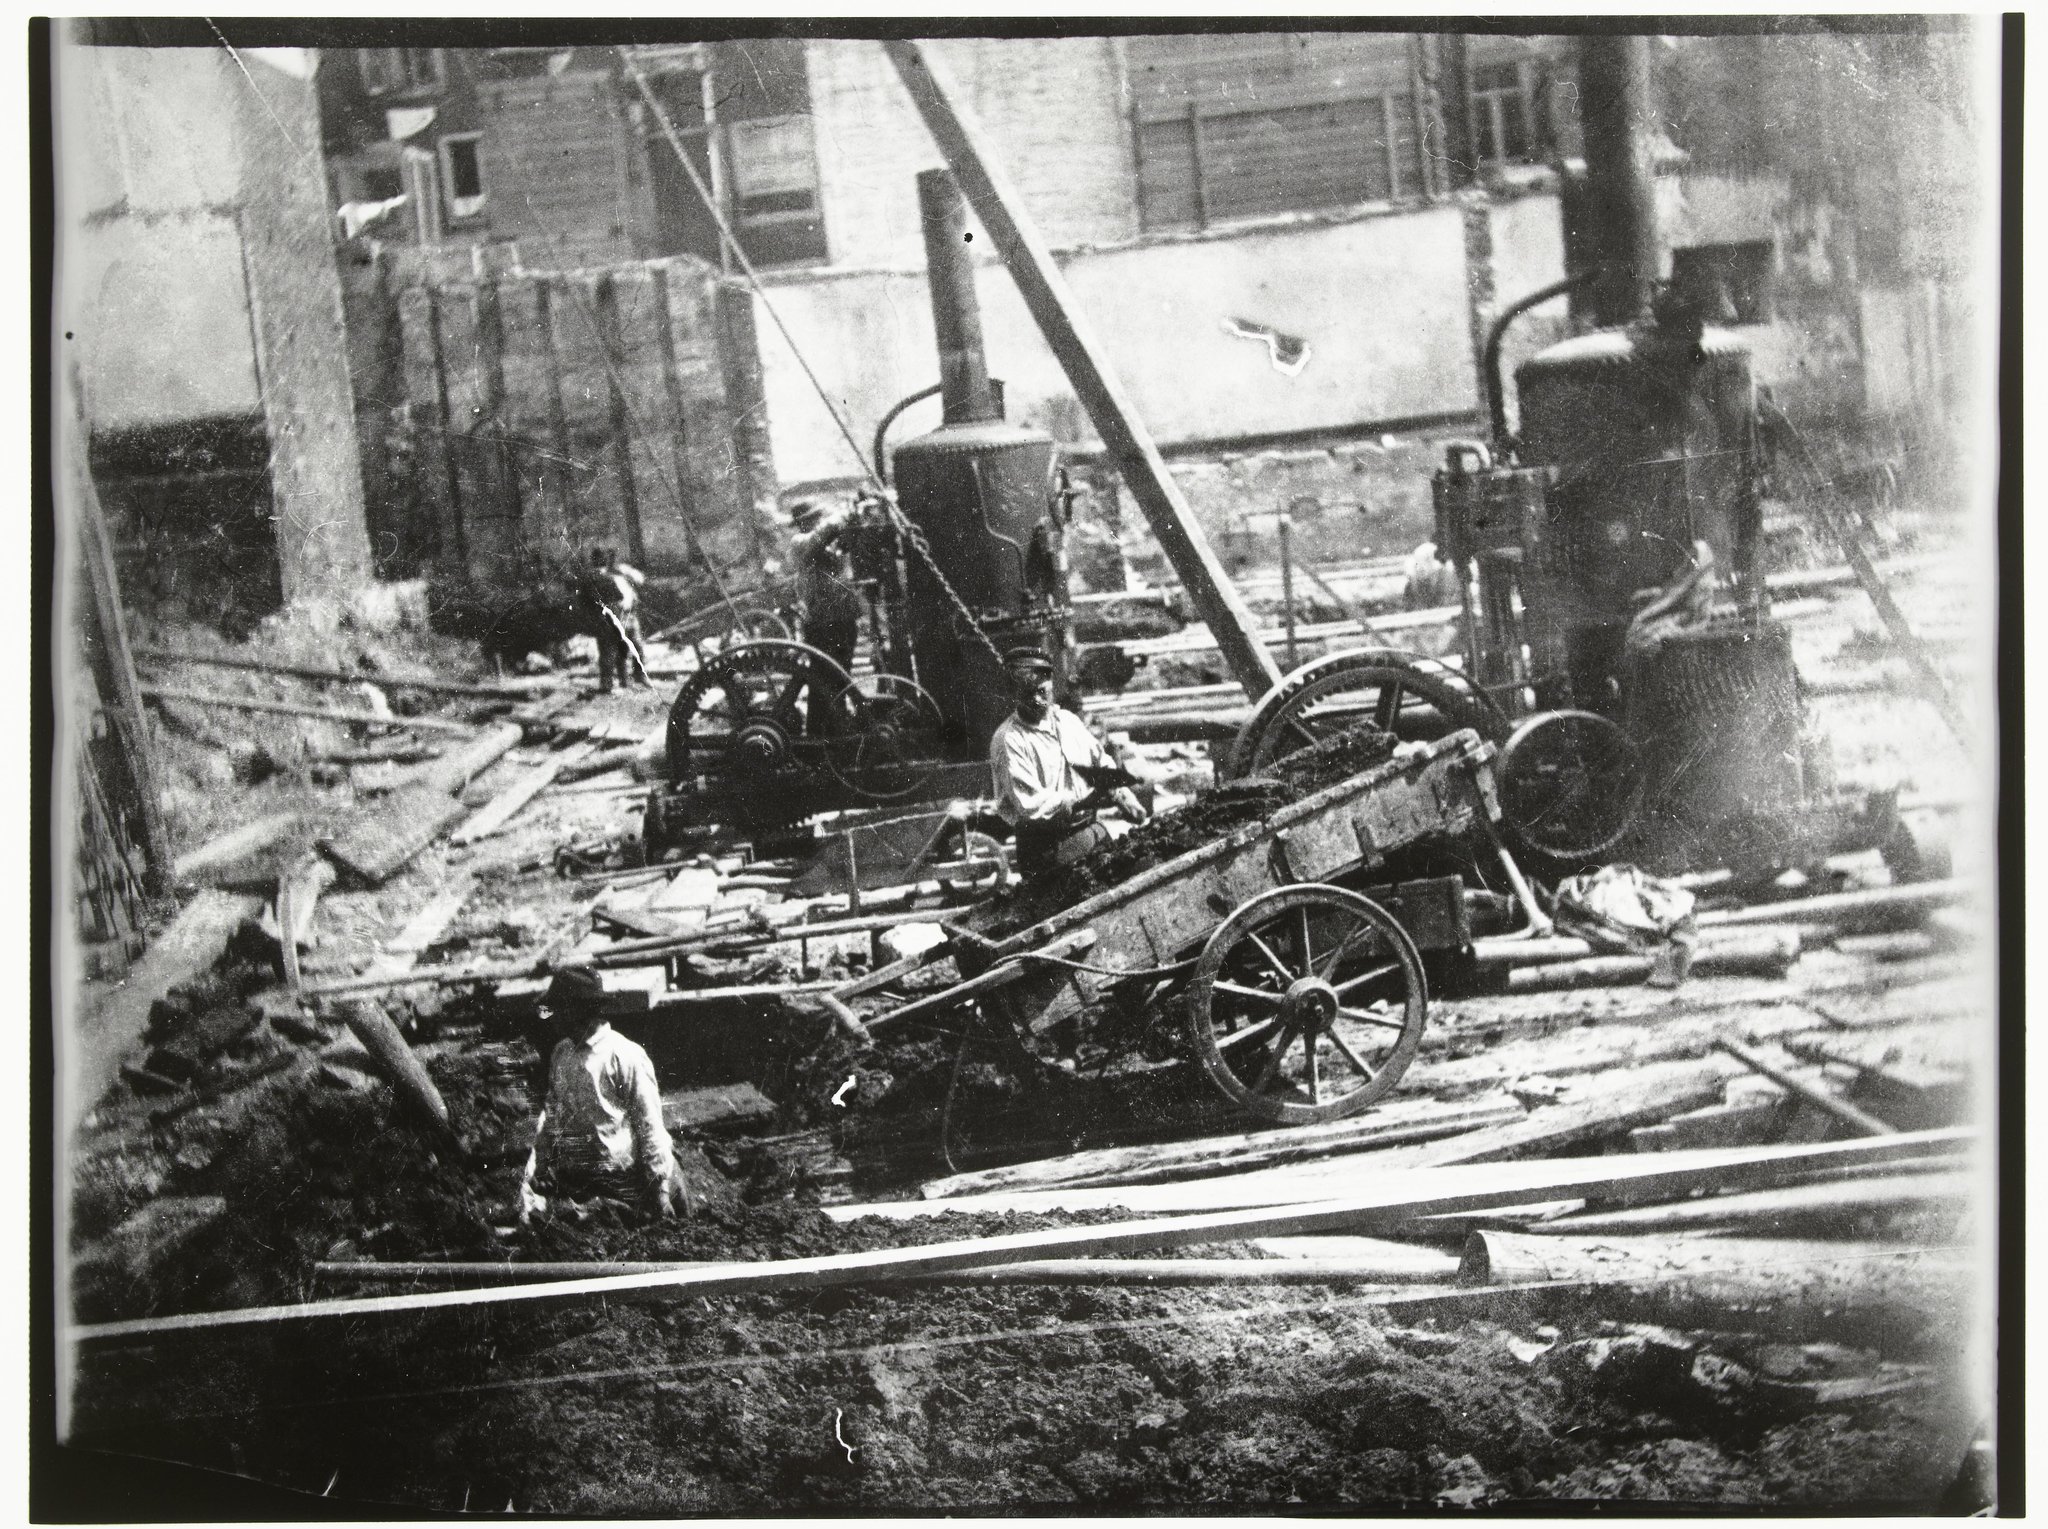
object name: photograph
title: Bouwput voor de Gemeentelijke Bad- en Zweminrichting aan de Heiligeweg in Amsterdam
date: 1890-1910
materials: paper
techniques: gelatin silver print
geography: netherlands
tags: heiligeweg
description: Moderne afdruk van negatief BR 61 (collectie RKD).